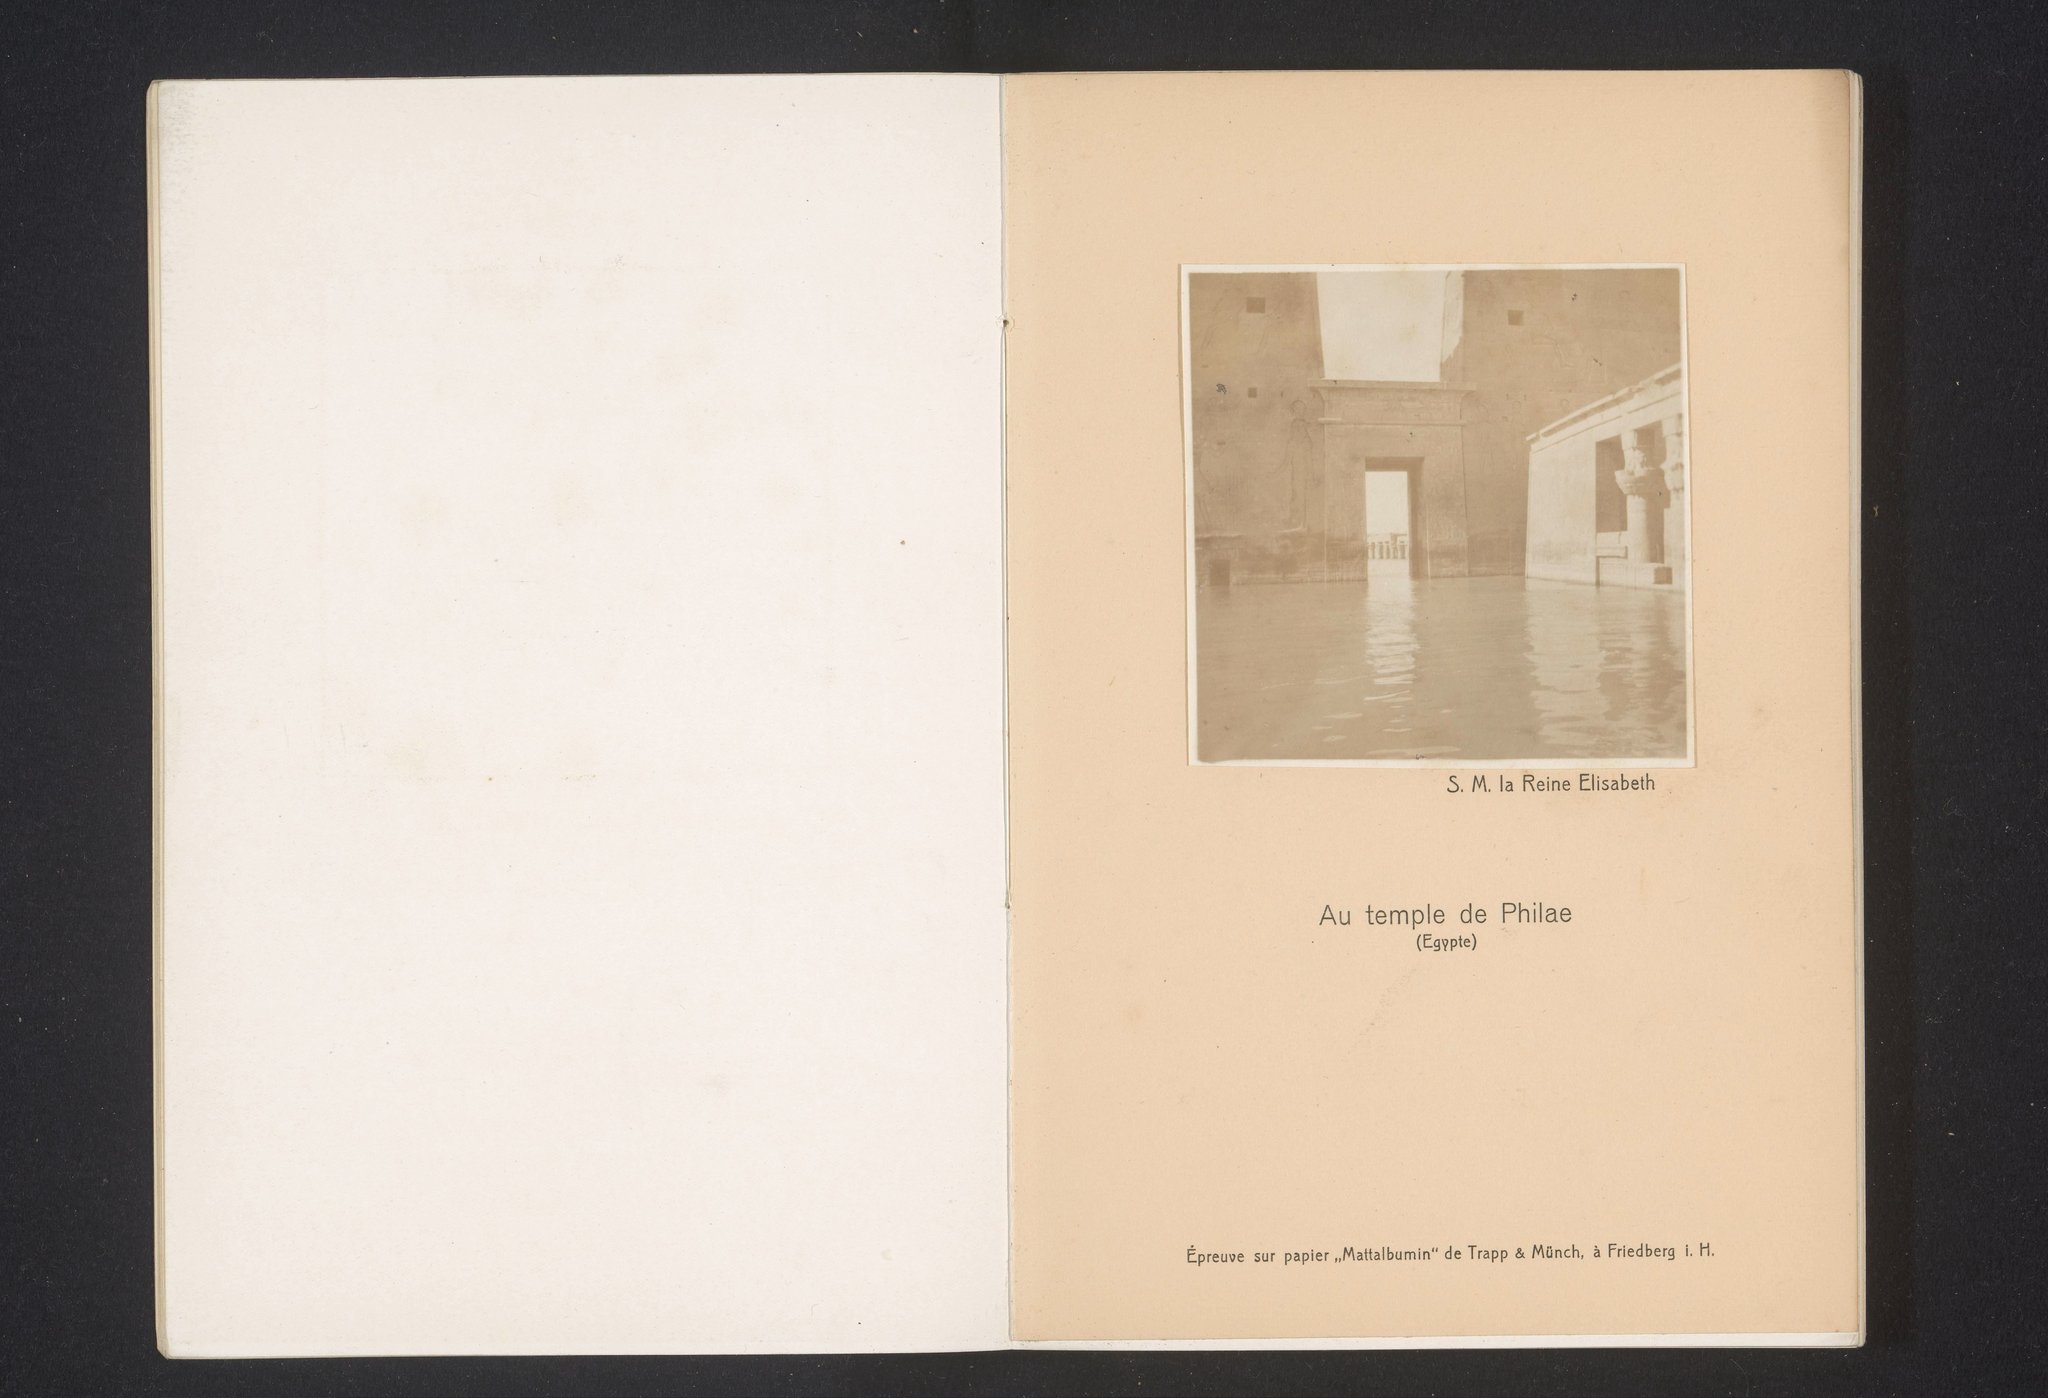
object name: photograph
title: Tempel van Philae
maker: elisabeth in beieren (koningin van belgië)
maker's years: 1876-1965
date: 1908-1913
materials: photographic support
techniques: albumen print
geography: philae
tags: temple, shrine ~ non-christian religions, egyptian hieroglyphs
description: Foto op zesde ongenummerde pagina na titelpagina.